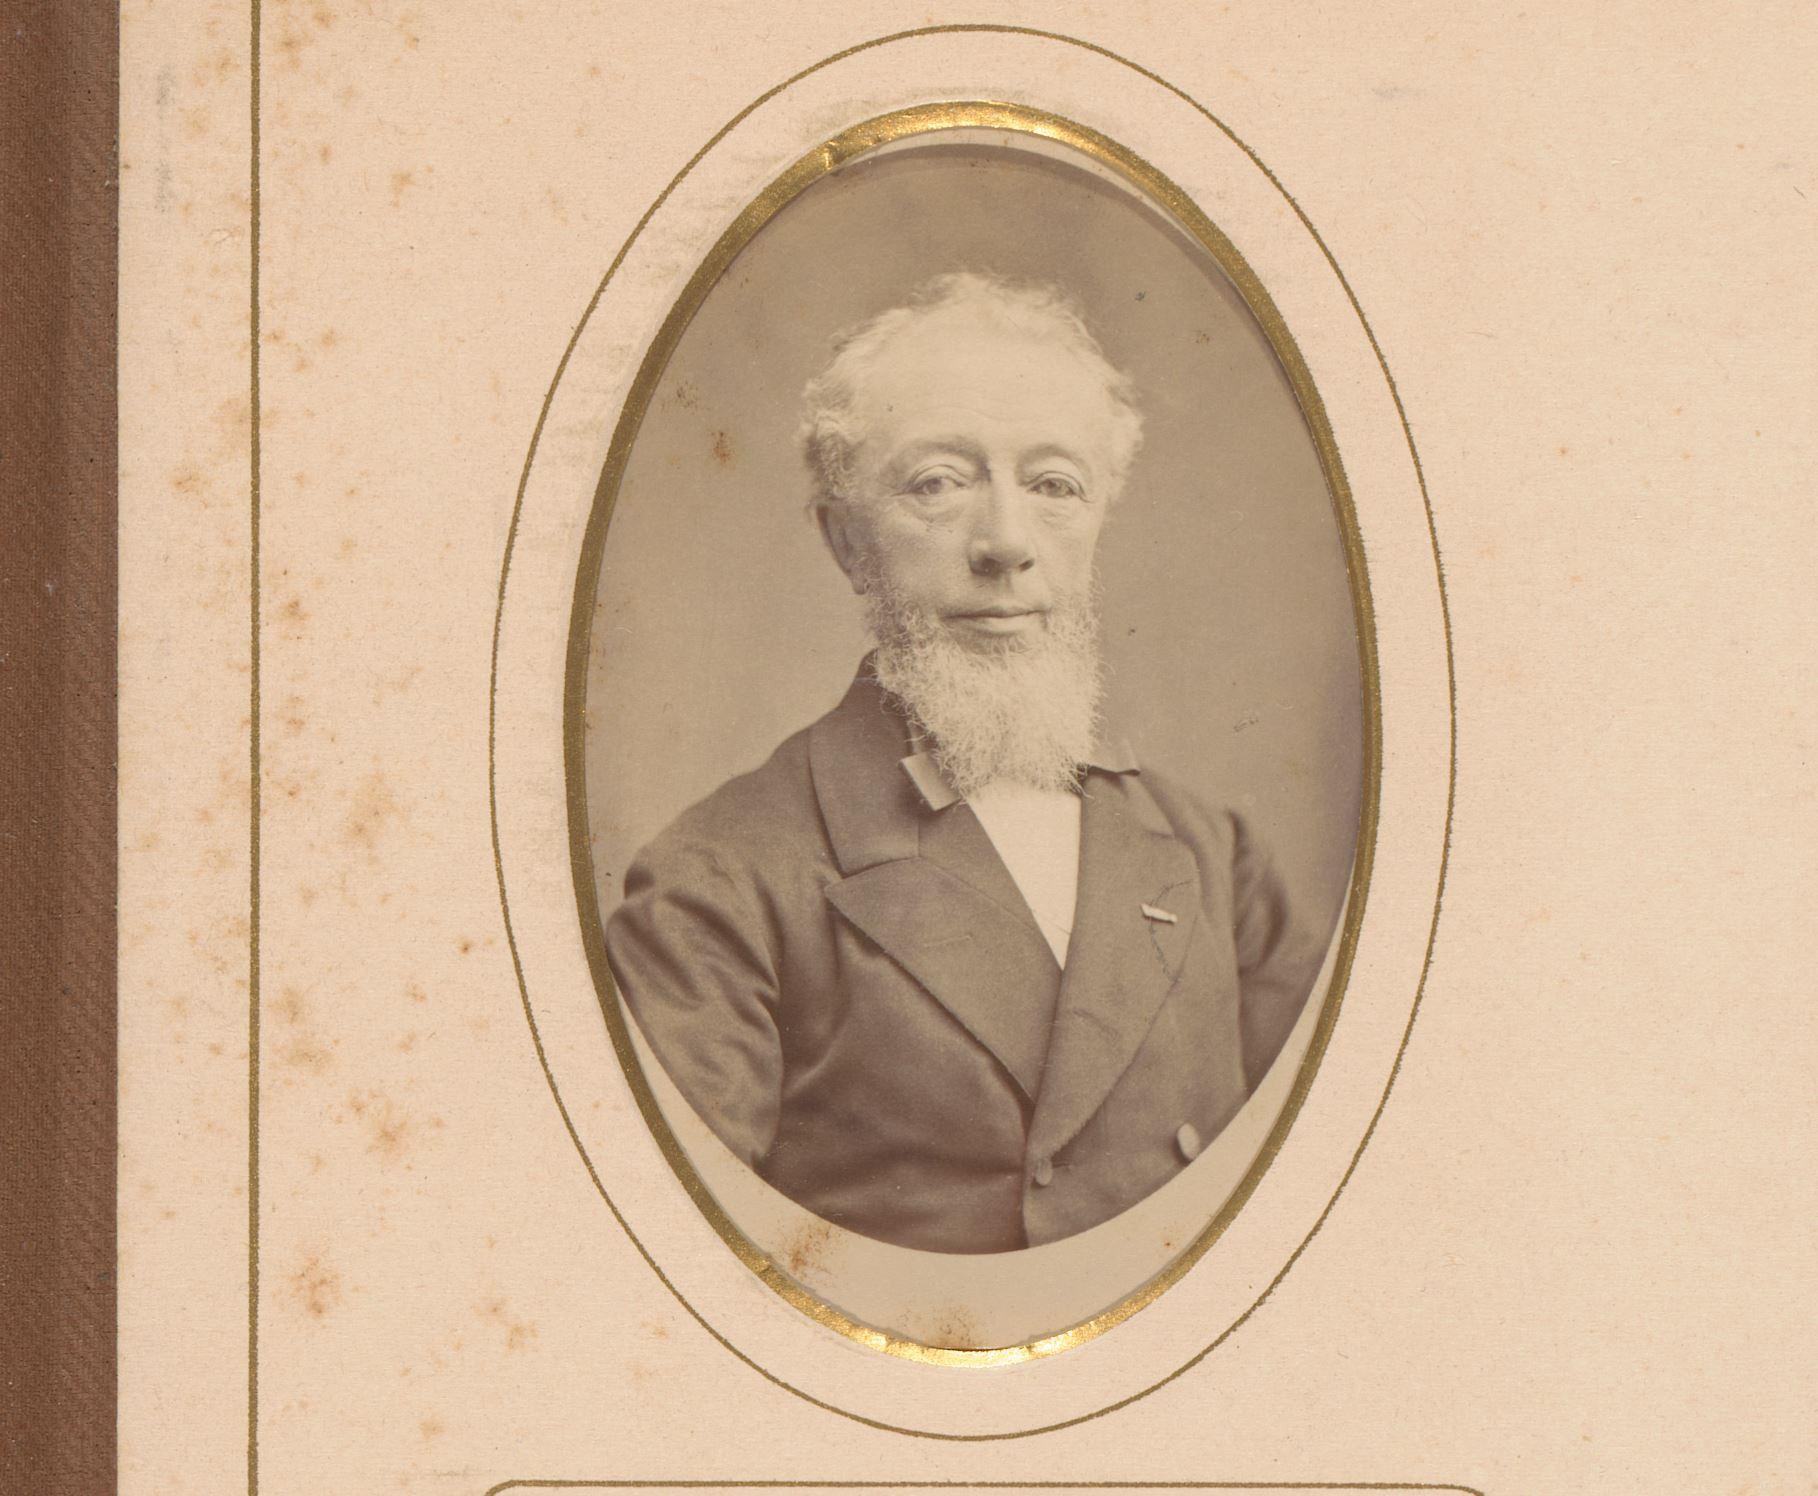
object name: carte de visite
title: Portret van een man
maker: jacob kuyper (1851-1919)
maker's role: fotograaf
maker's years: 1851-1919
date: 1877-1900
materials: cardboard, photographic support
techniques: gelatin silver print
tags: historical persons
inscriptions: inscription: ‘Photographisch Atelier/ J. Kuyper/ voorheen/ J. Breebaard/ ZAANDAM/ (westzijde bij de Kerk.)/ Salon Portretten naar alle bestaande/ Photographien./ De platen blijven voor nabestellingen/ bewaard.’